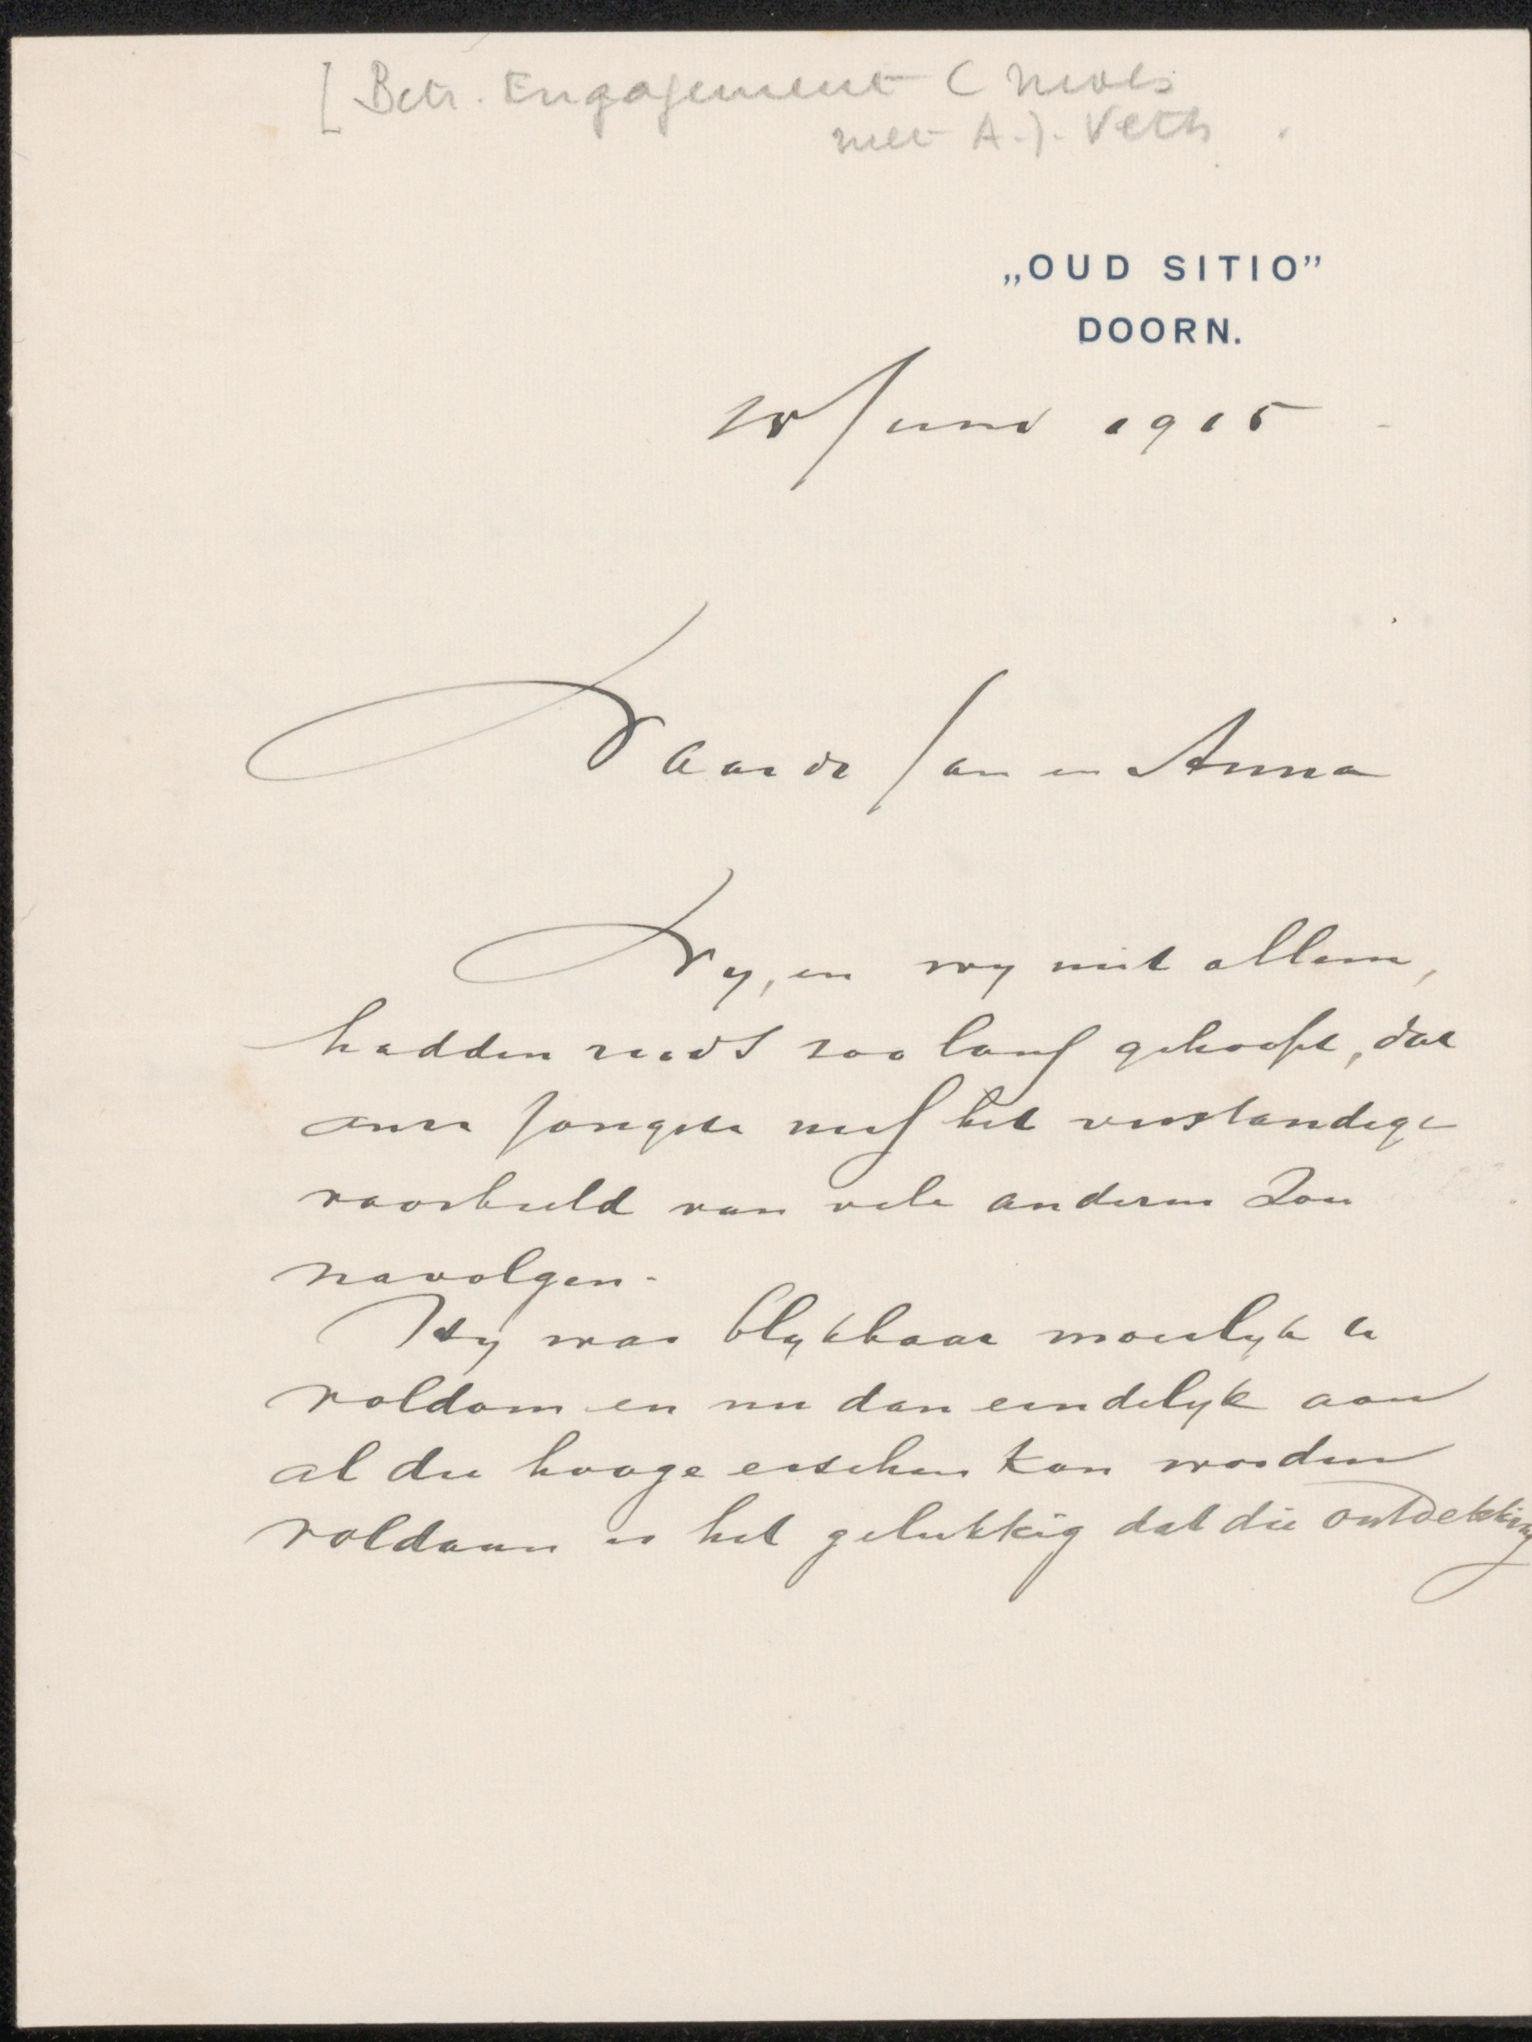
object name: letter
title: Brief aan Jan Veth en Anna Dorothea Dirks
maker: cornelis gerardus t hooft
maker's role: draughtsman, painter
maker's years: 1866-1936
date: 1915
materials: ink, paper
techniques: pen, printing, writing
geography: doorn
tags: dordrecht, amsterdam, painter, draughtsman, designer, jan veth, artist, anna dorothea dirks, family life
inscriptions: collector's mark: ‘RPK’